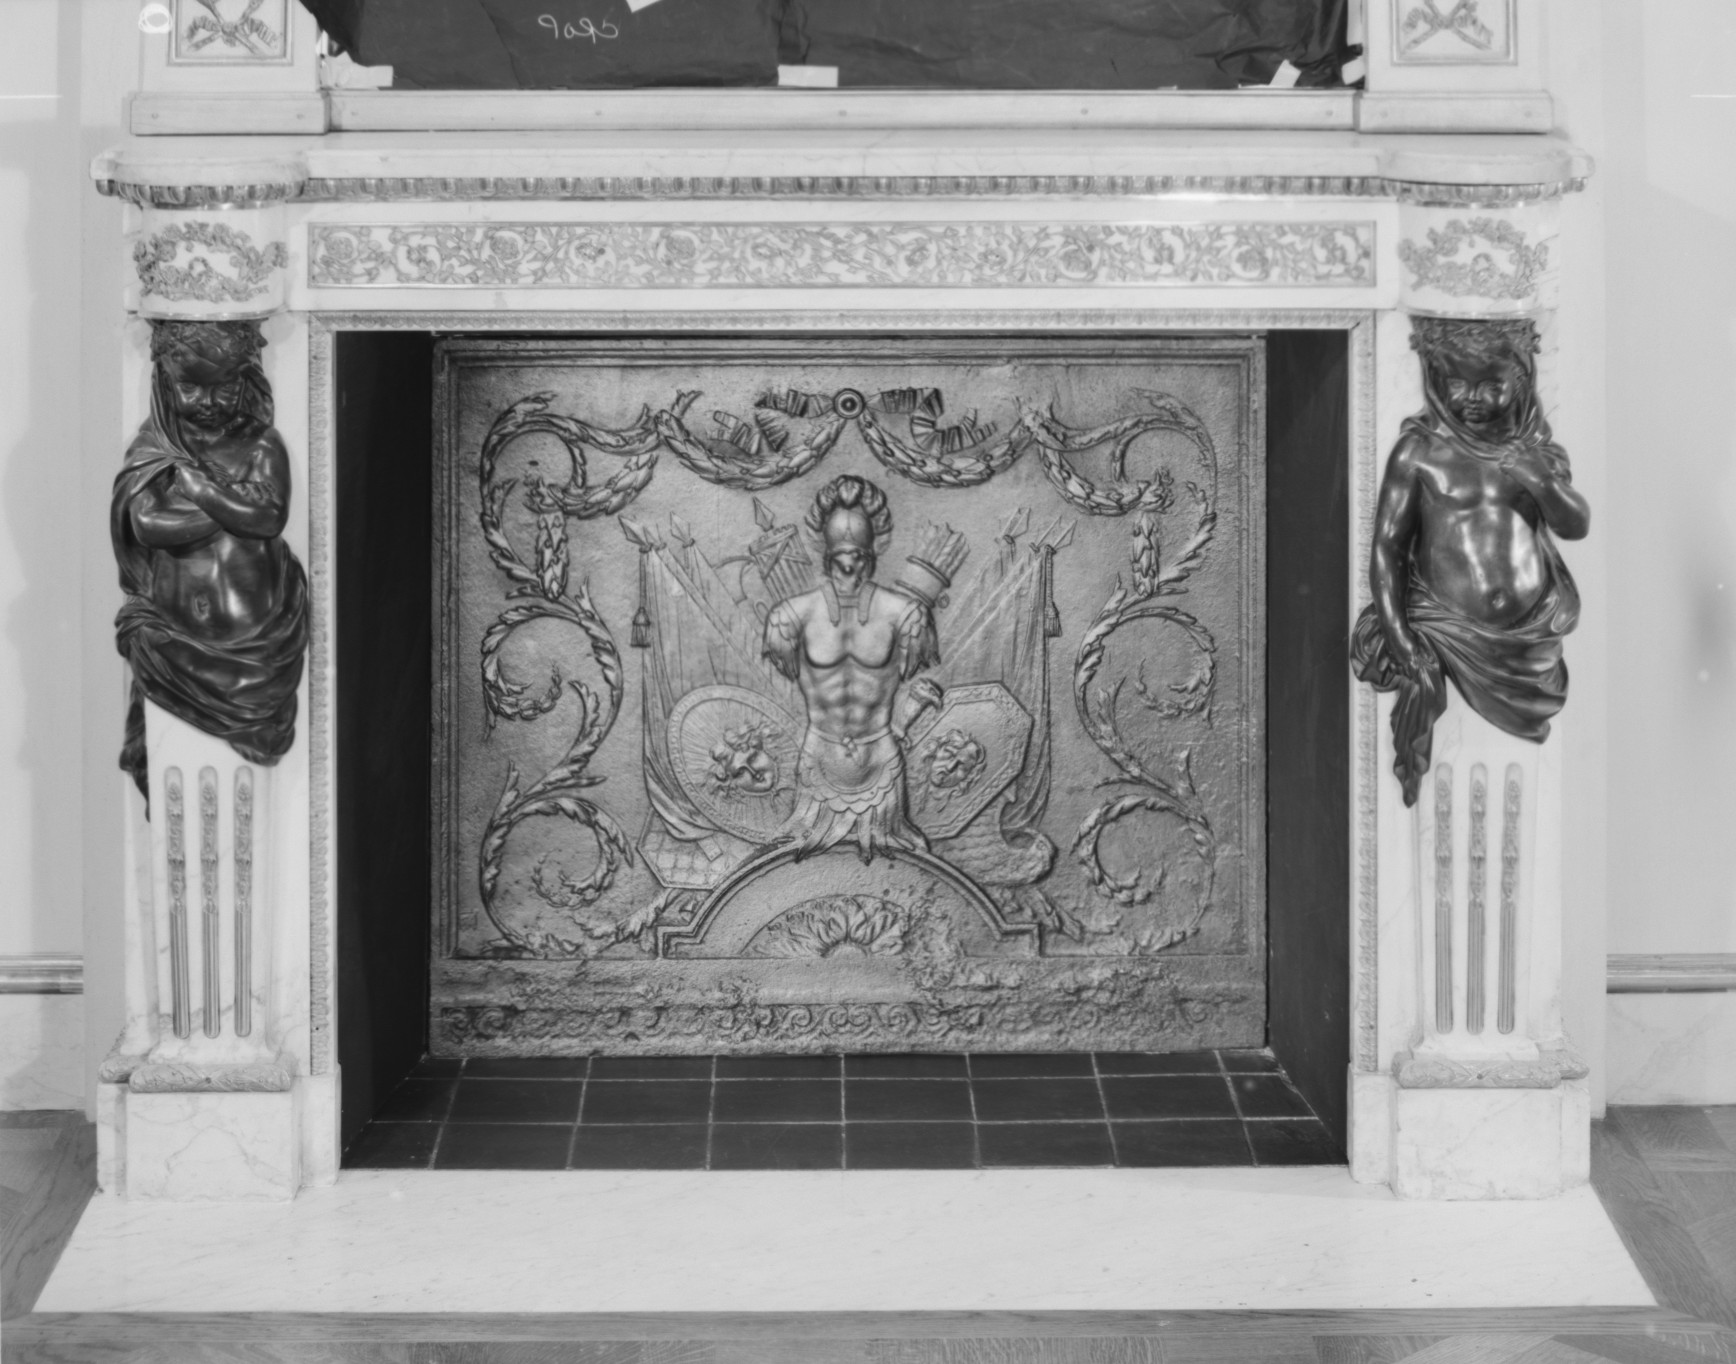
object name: chimneypiece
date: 1801-1900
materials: bronze, gilt, marble